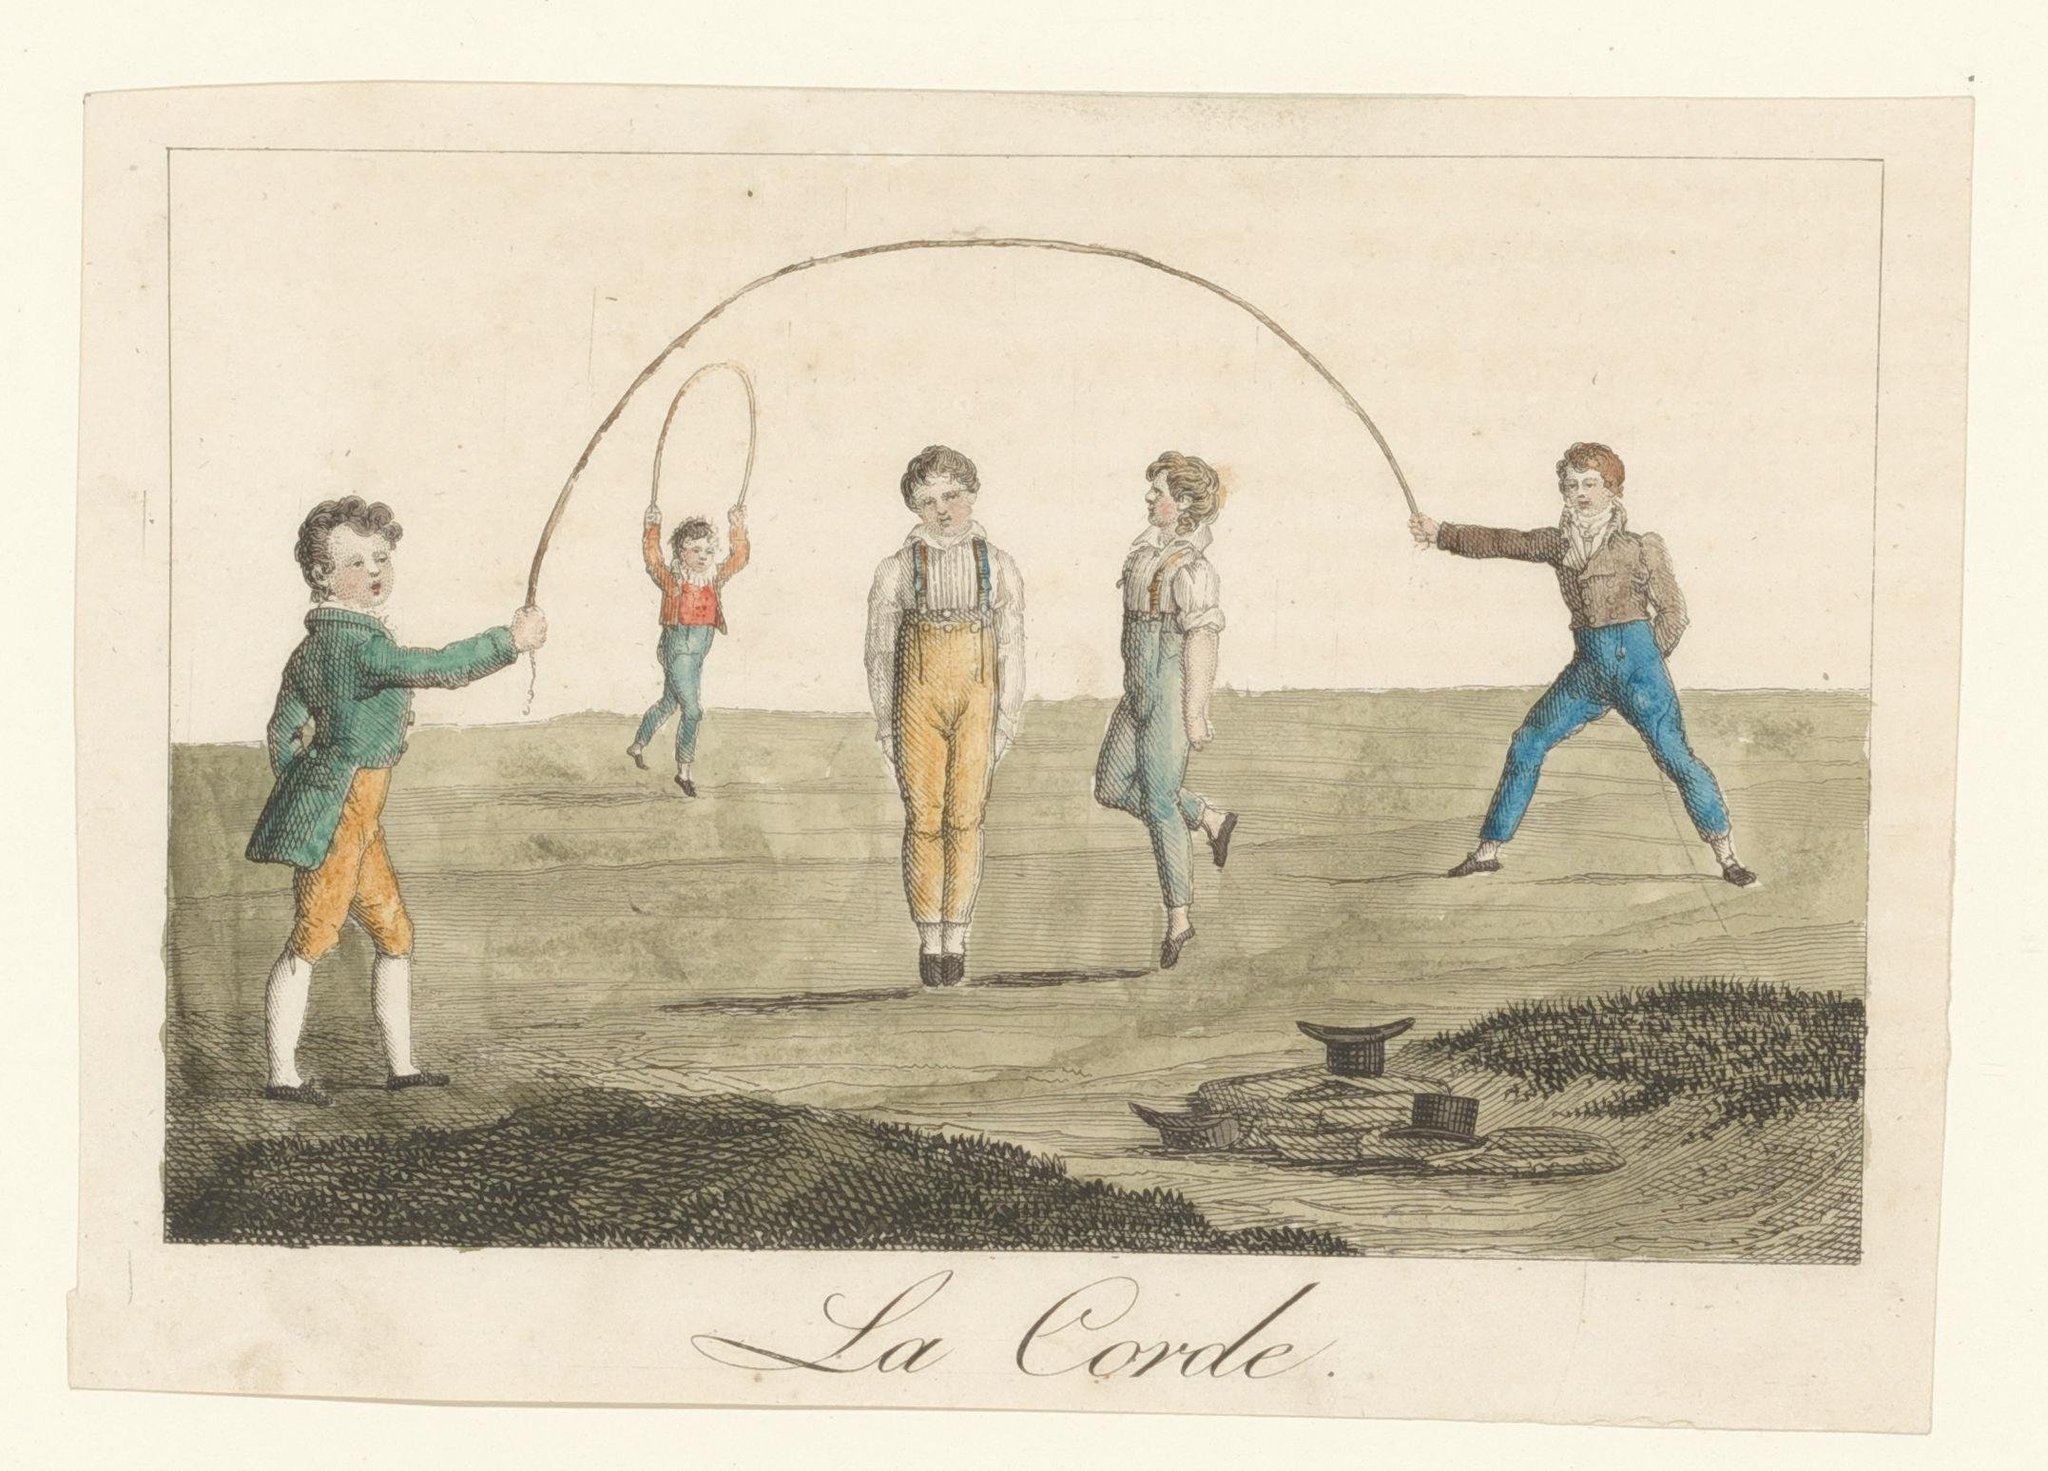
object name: print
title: Kinderen springen touwtje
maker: Anonymous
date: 1800-1899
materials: paper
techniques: etching, hand coloring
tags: children's games and plays, child, jumping-rope games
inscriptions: collector's mark: Lugt 1641, stamp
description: Onderwerpsrubrieken binnen de Atlas Zeden en Gewoonten: Zeden en Gewoonten in Engeren Zin, Des menschen beging, midden en einde, Kinderleven – Kinderspel en Kinderprenten.